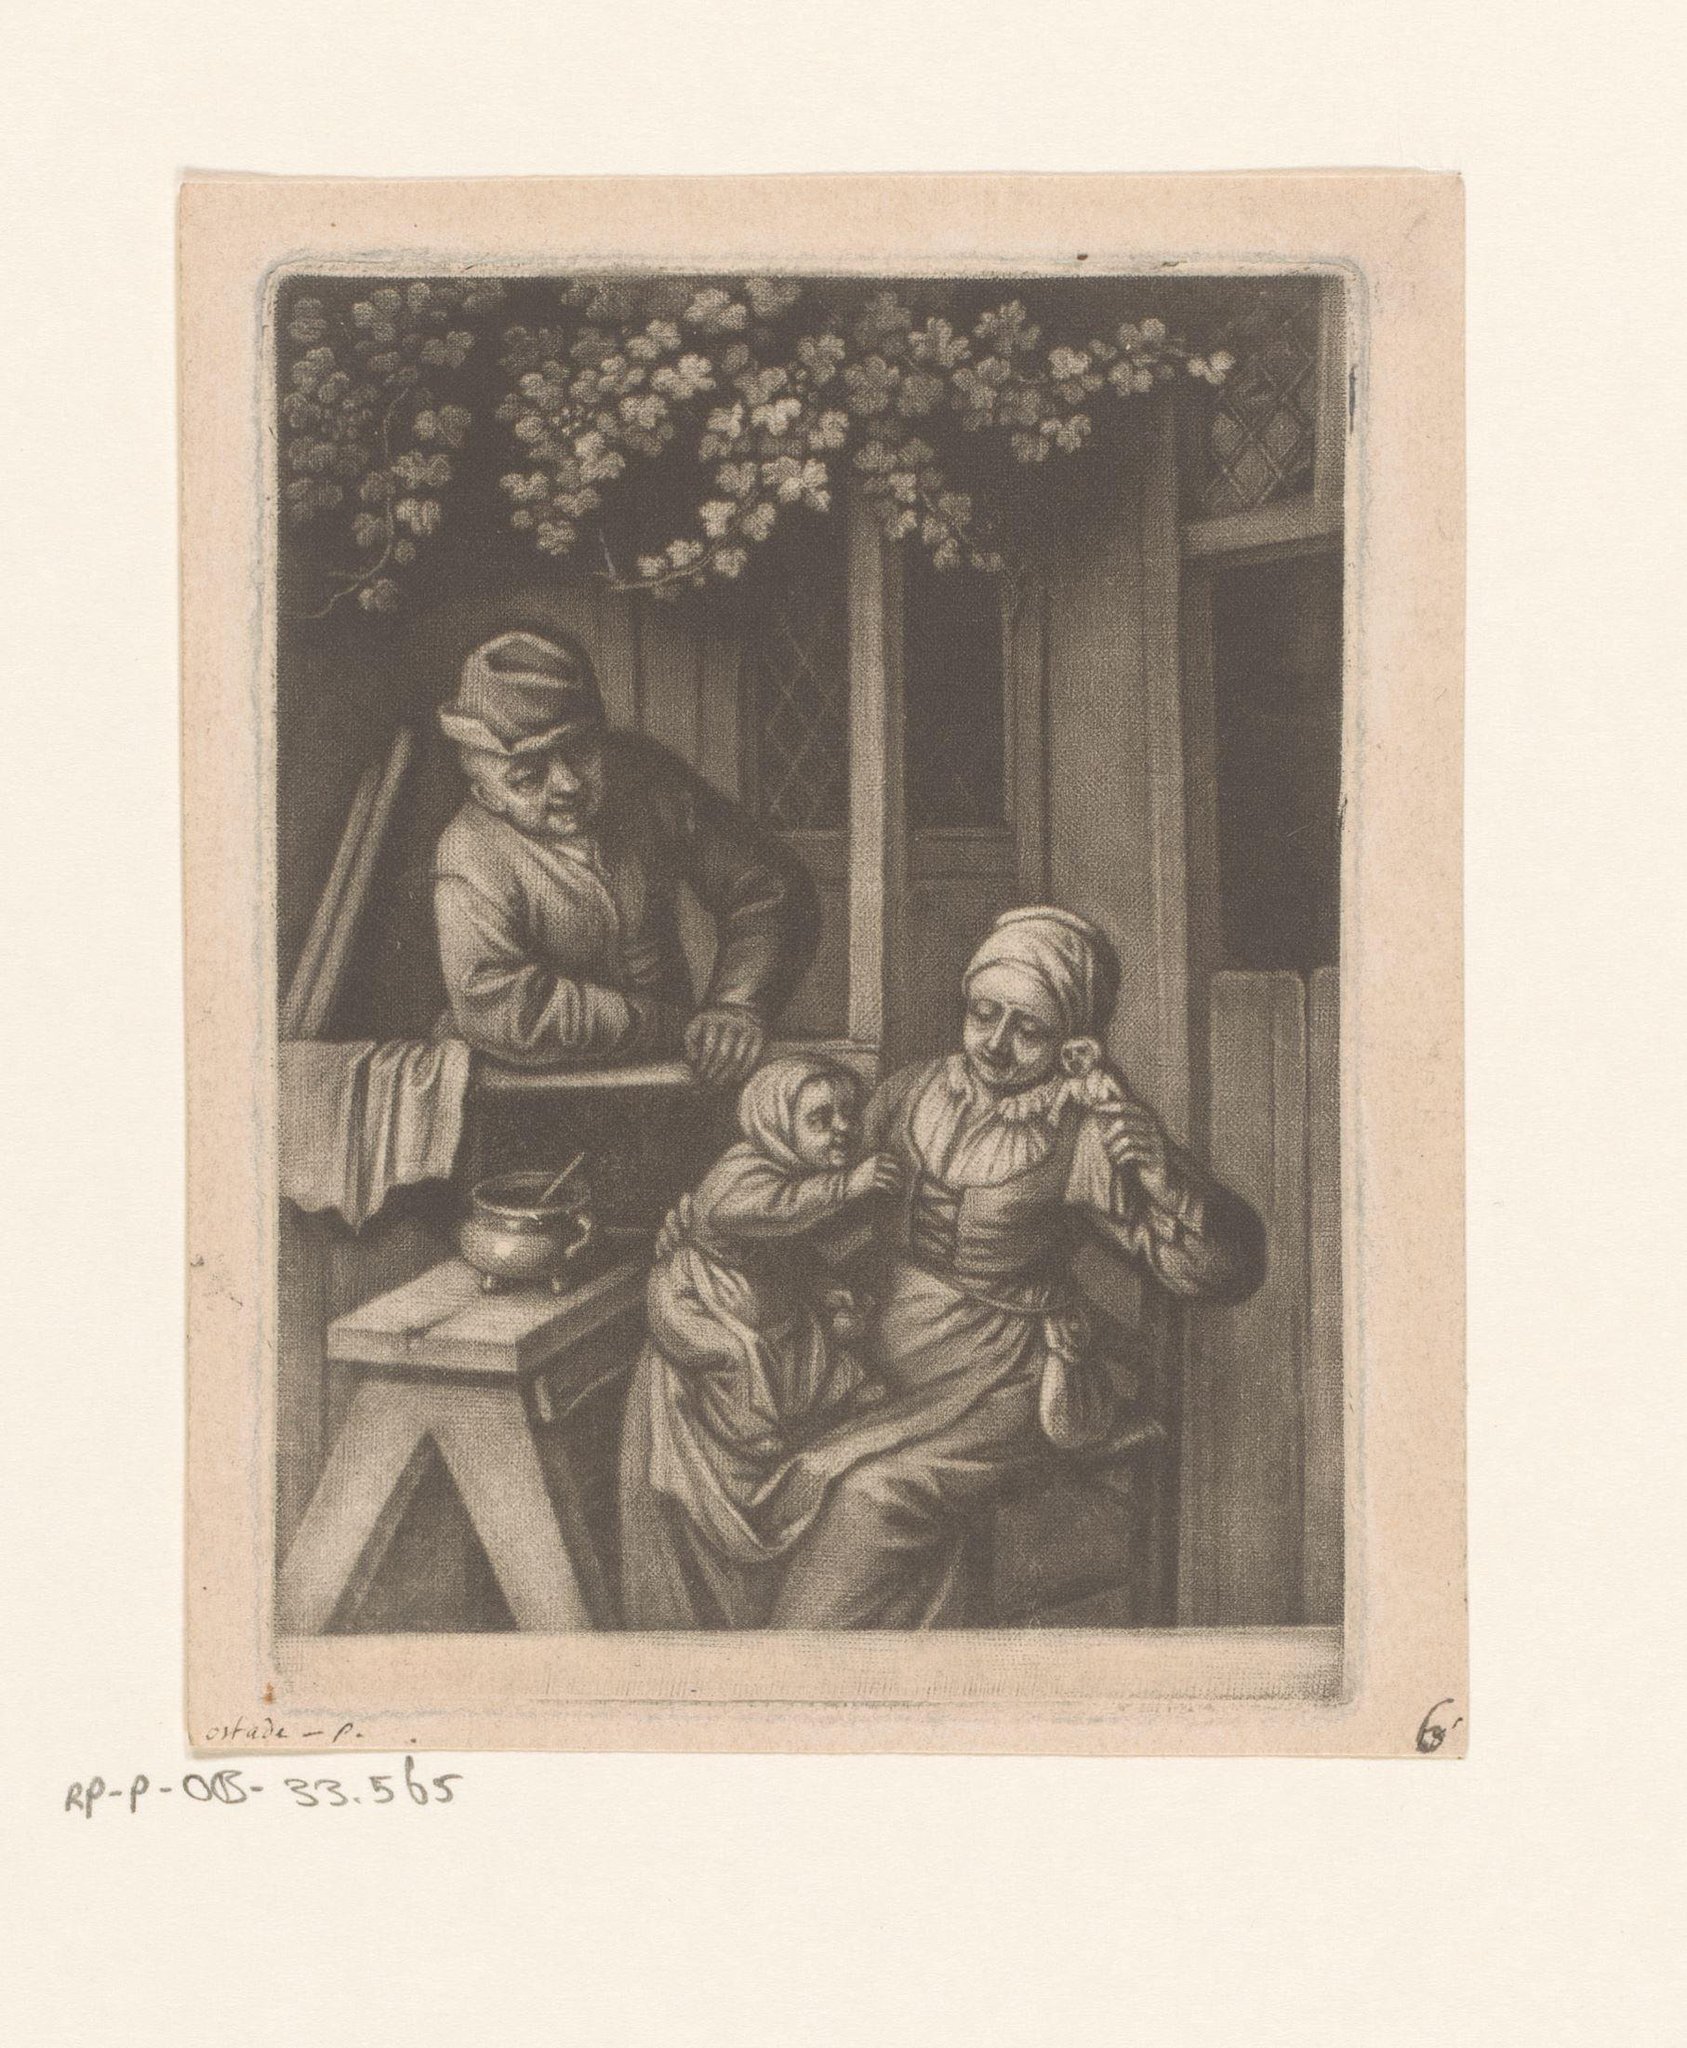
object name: print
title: Familie voor een huis met vrouw die pop voor een kind houdt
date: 1670-1720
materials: paper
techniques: mezzotint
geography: england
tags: mother playing with baby (fondling, dandling, crooning) - aa - other person than mother playing with baby, (playing with) dolls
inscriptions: collector's mark: Lugt 240